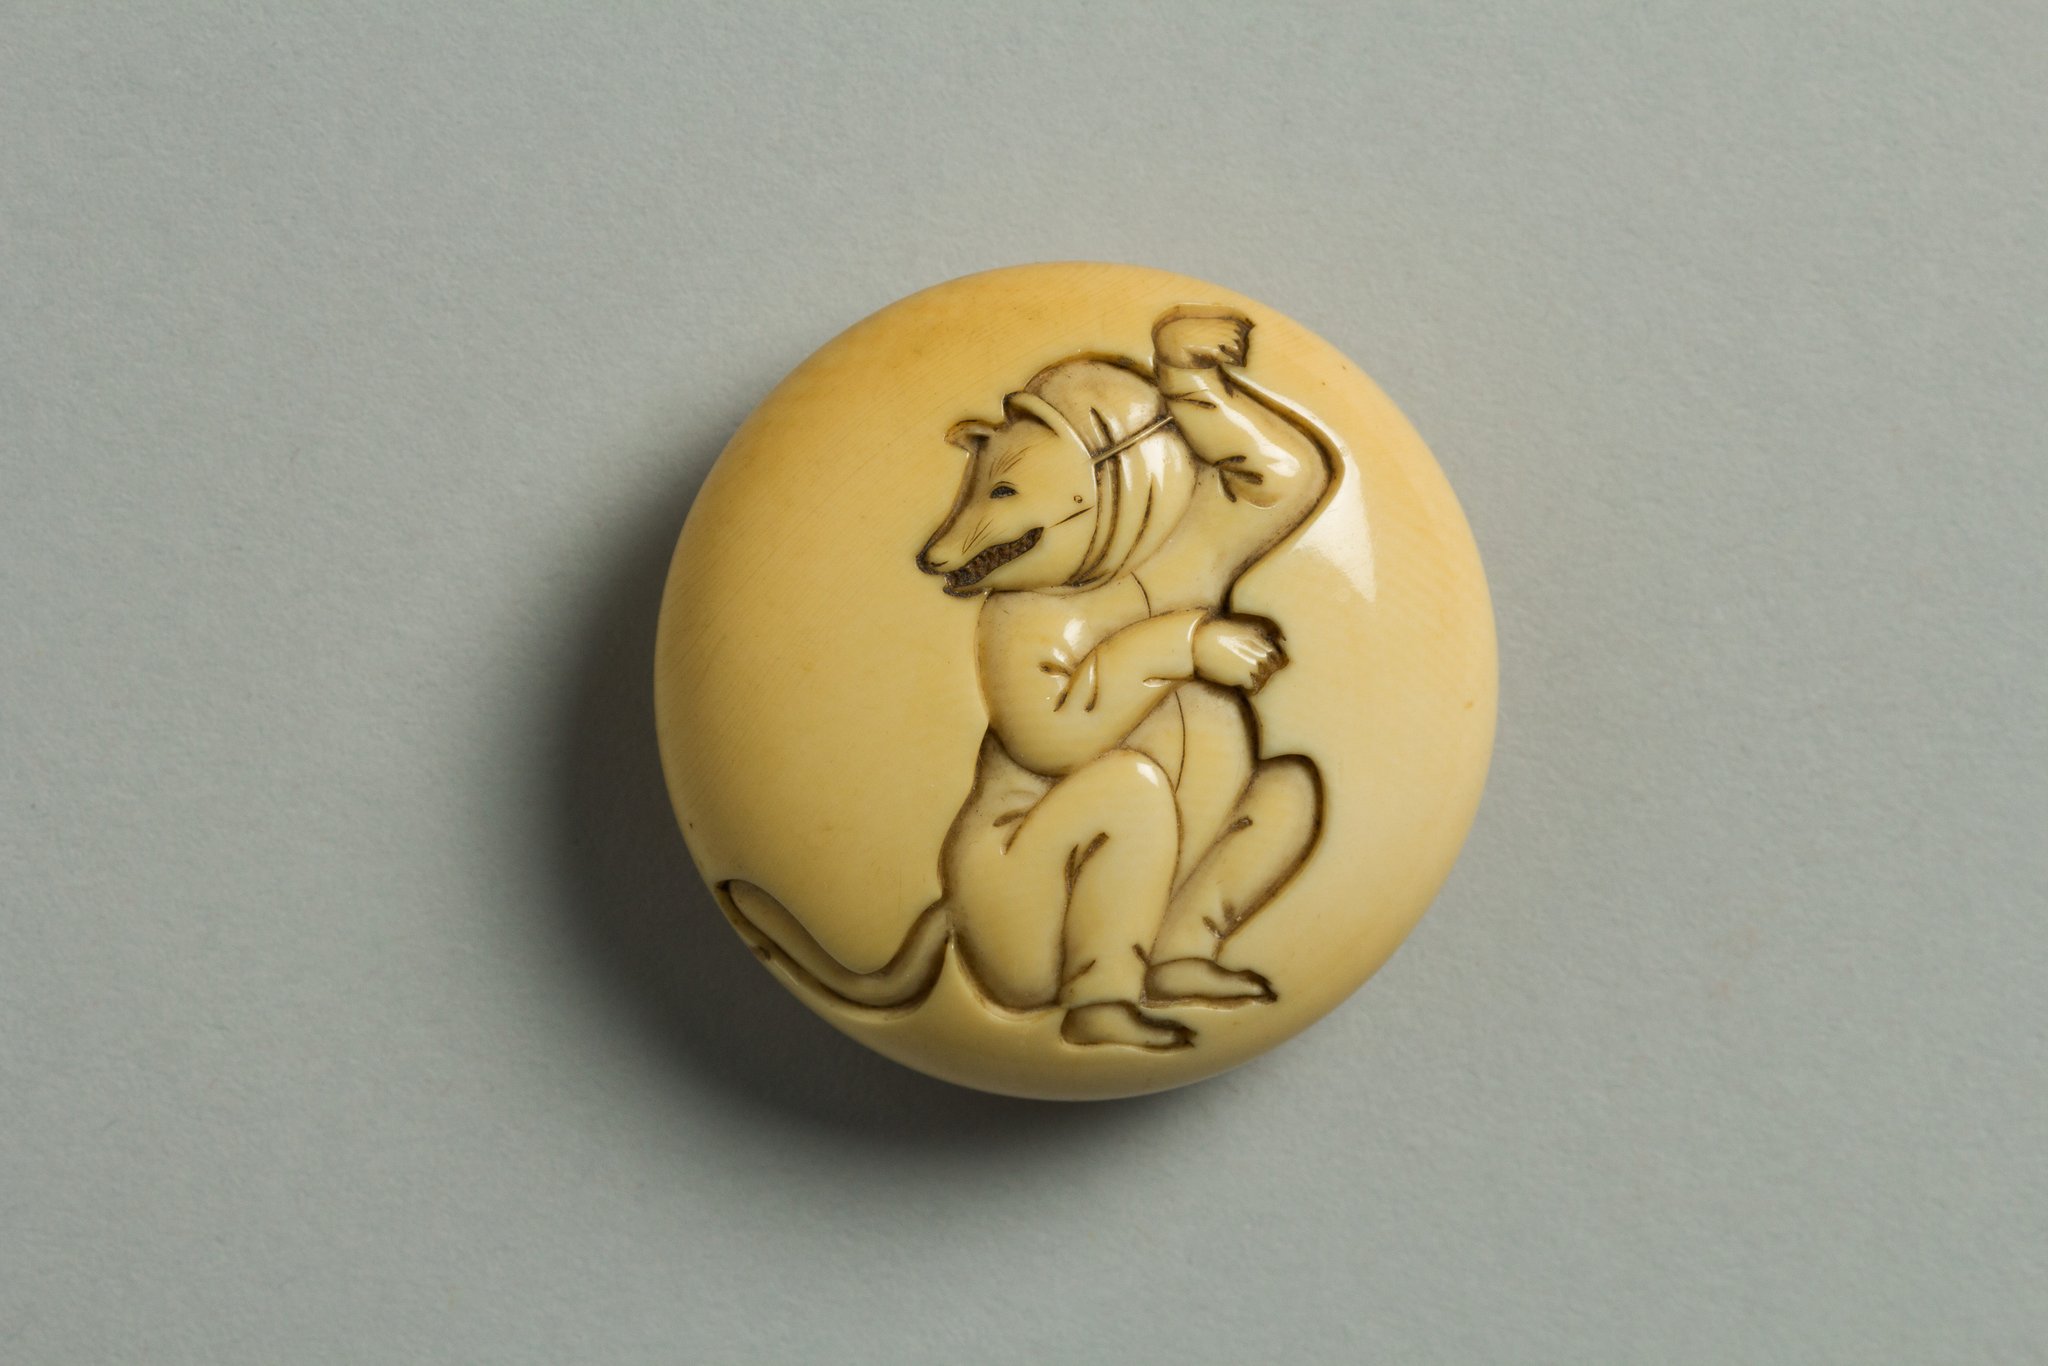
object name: netsuke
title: Circular Netsuke with Actor Dressed as Fox; reverse: Trap with Mouse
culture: japanese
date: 1801-1900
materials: ivory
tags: foxes